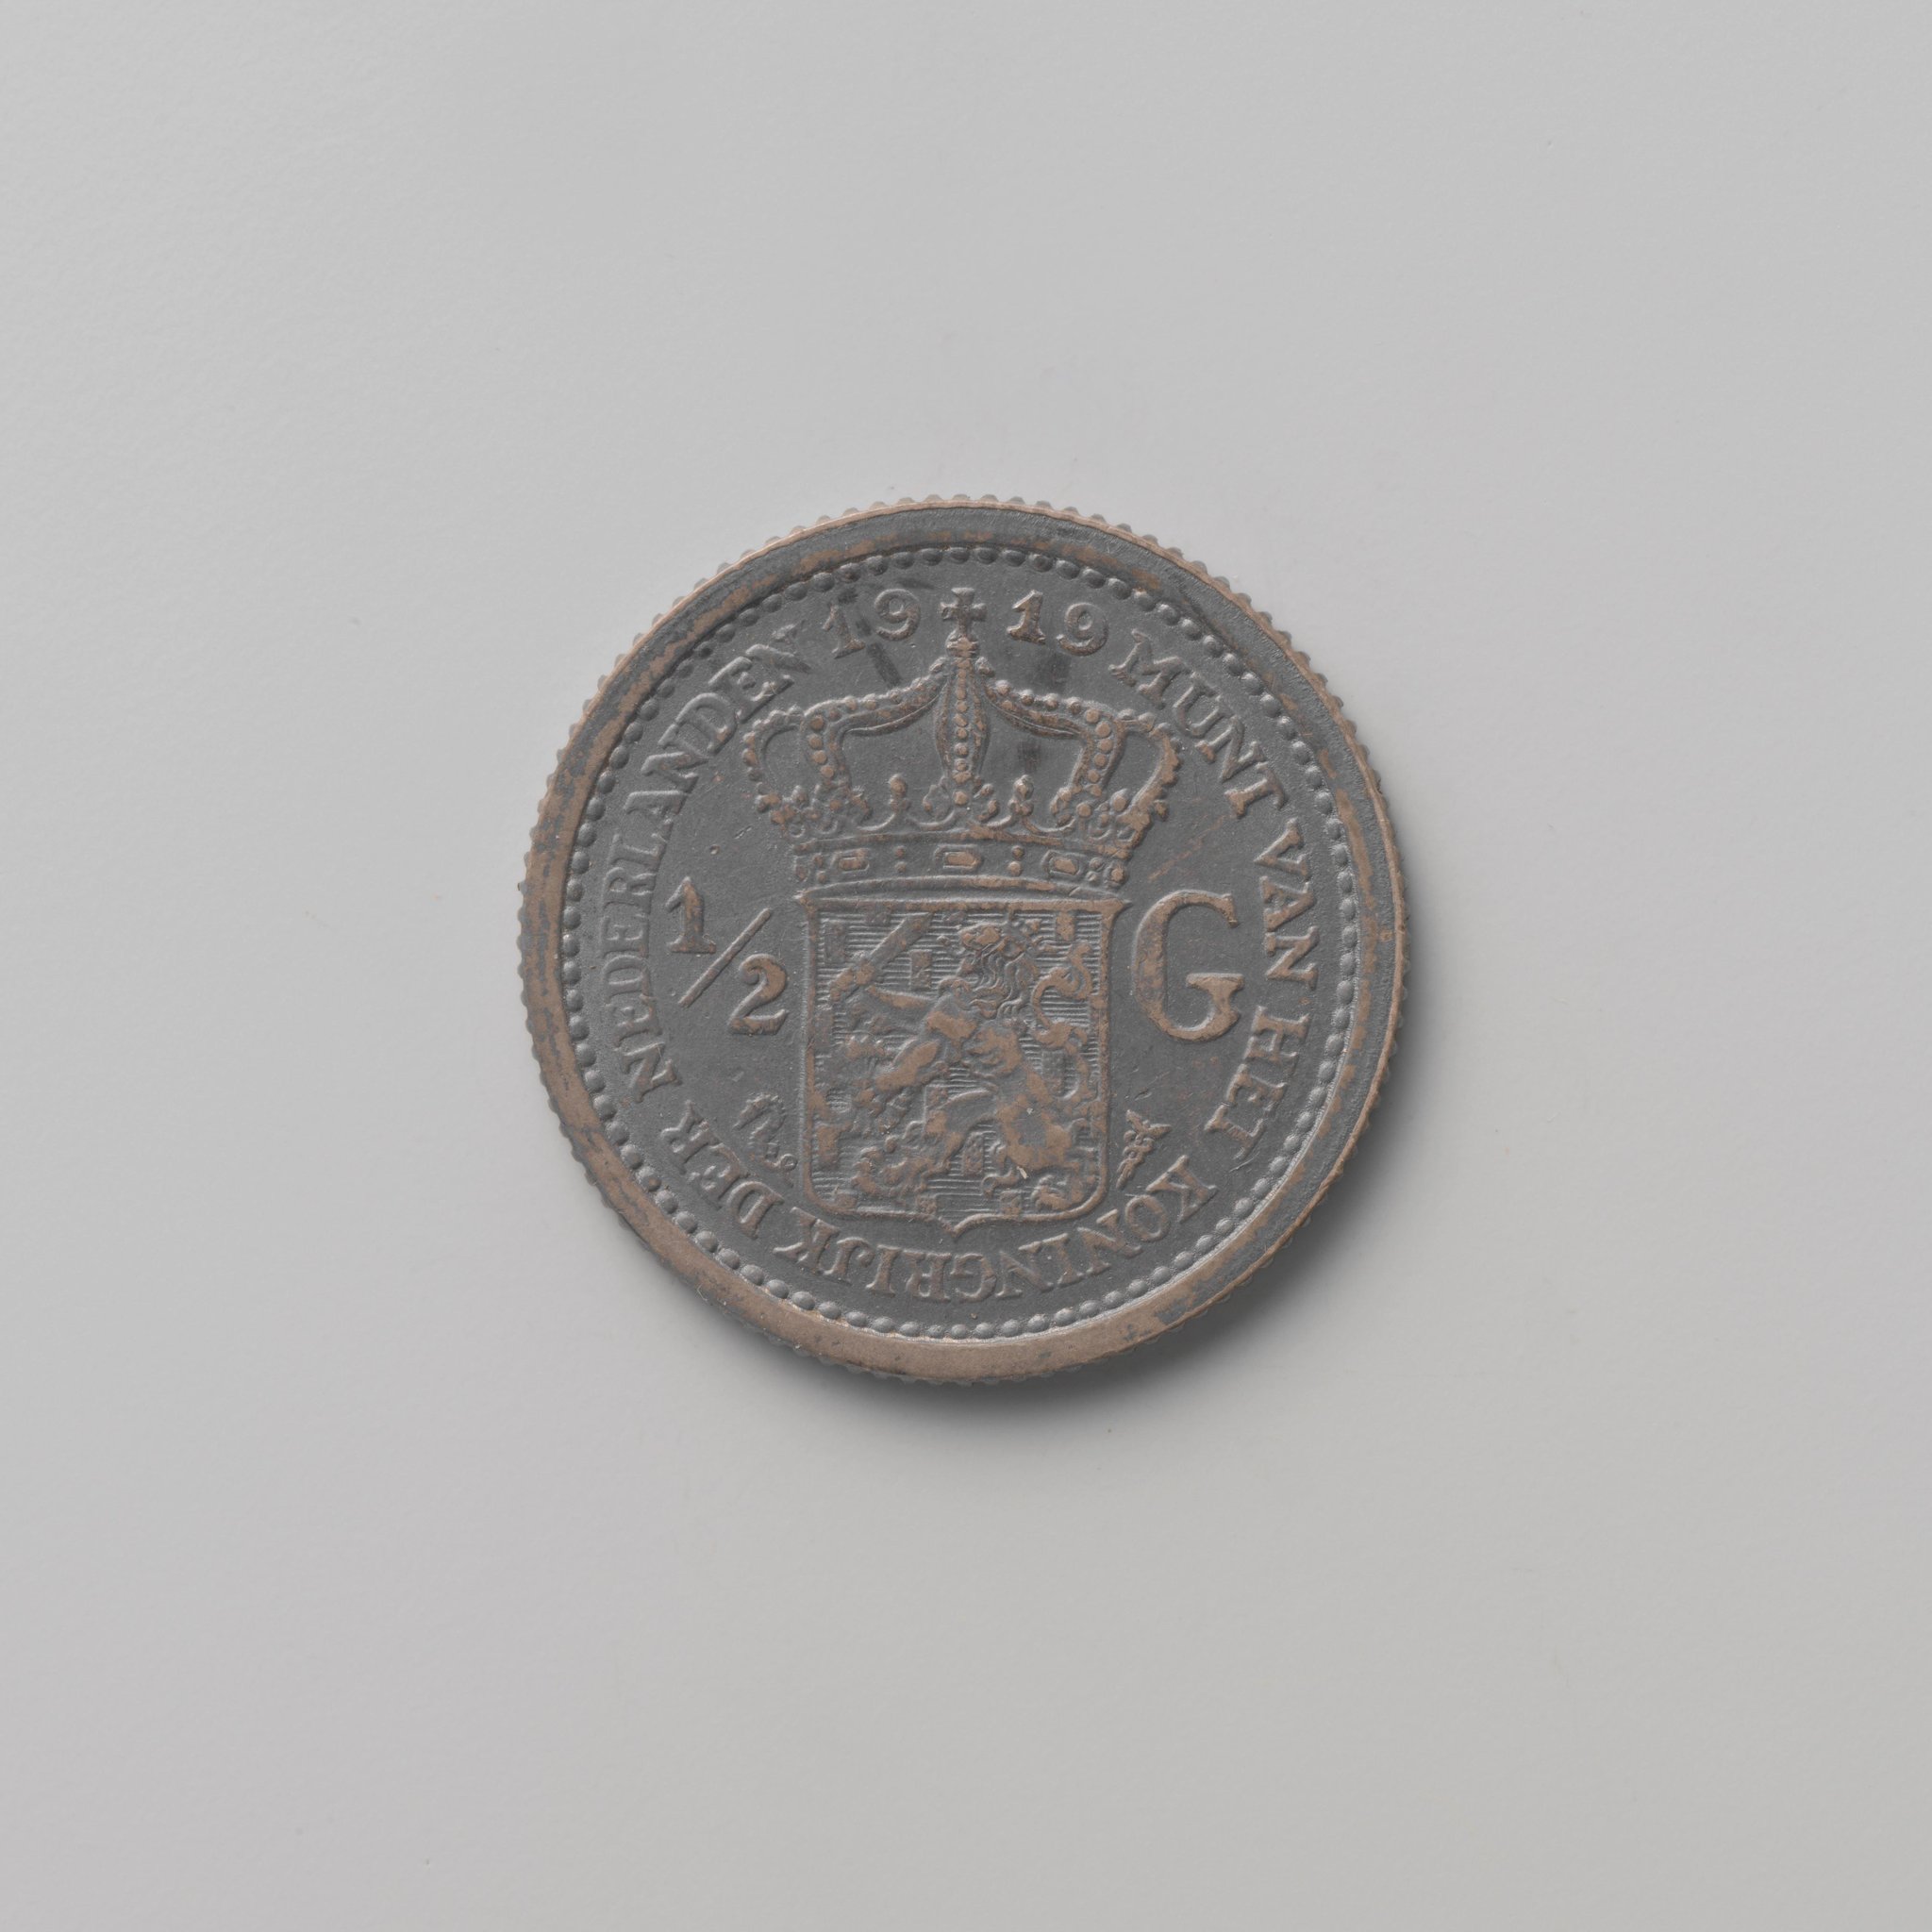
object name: coin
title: Nederland, ½ gulden,1919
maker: wilhelmina of the netherlands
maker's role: print maker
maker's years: 1880-1962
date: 1919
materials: silver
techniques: striking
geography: utrecht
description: Zilveren munt. Voorzijde: gedrapeerd borstbeeld met diadeem naar links. Keerzijde: tussen waarde-aanduiding ½ G gekroond rijkswapenschild. Jaartal bovenaan in omschrift. Kartelrand.